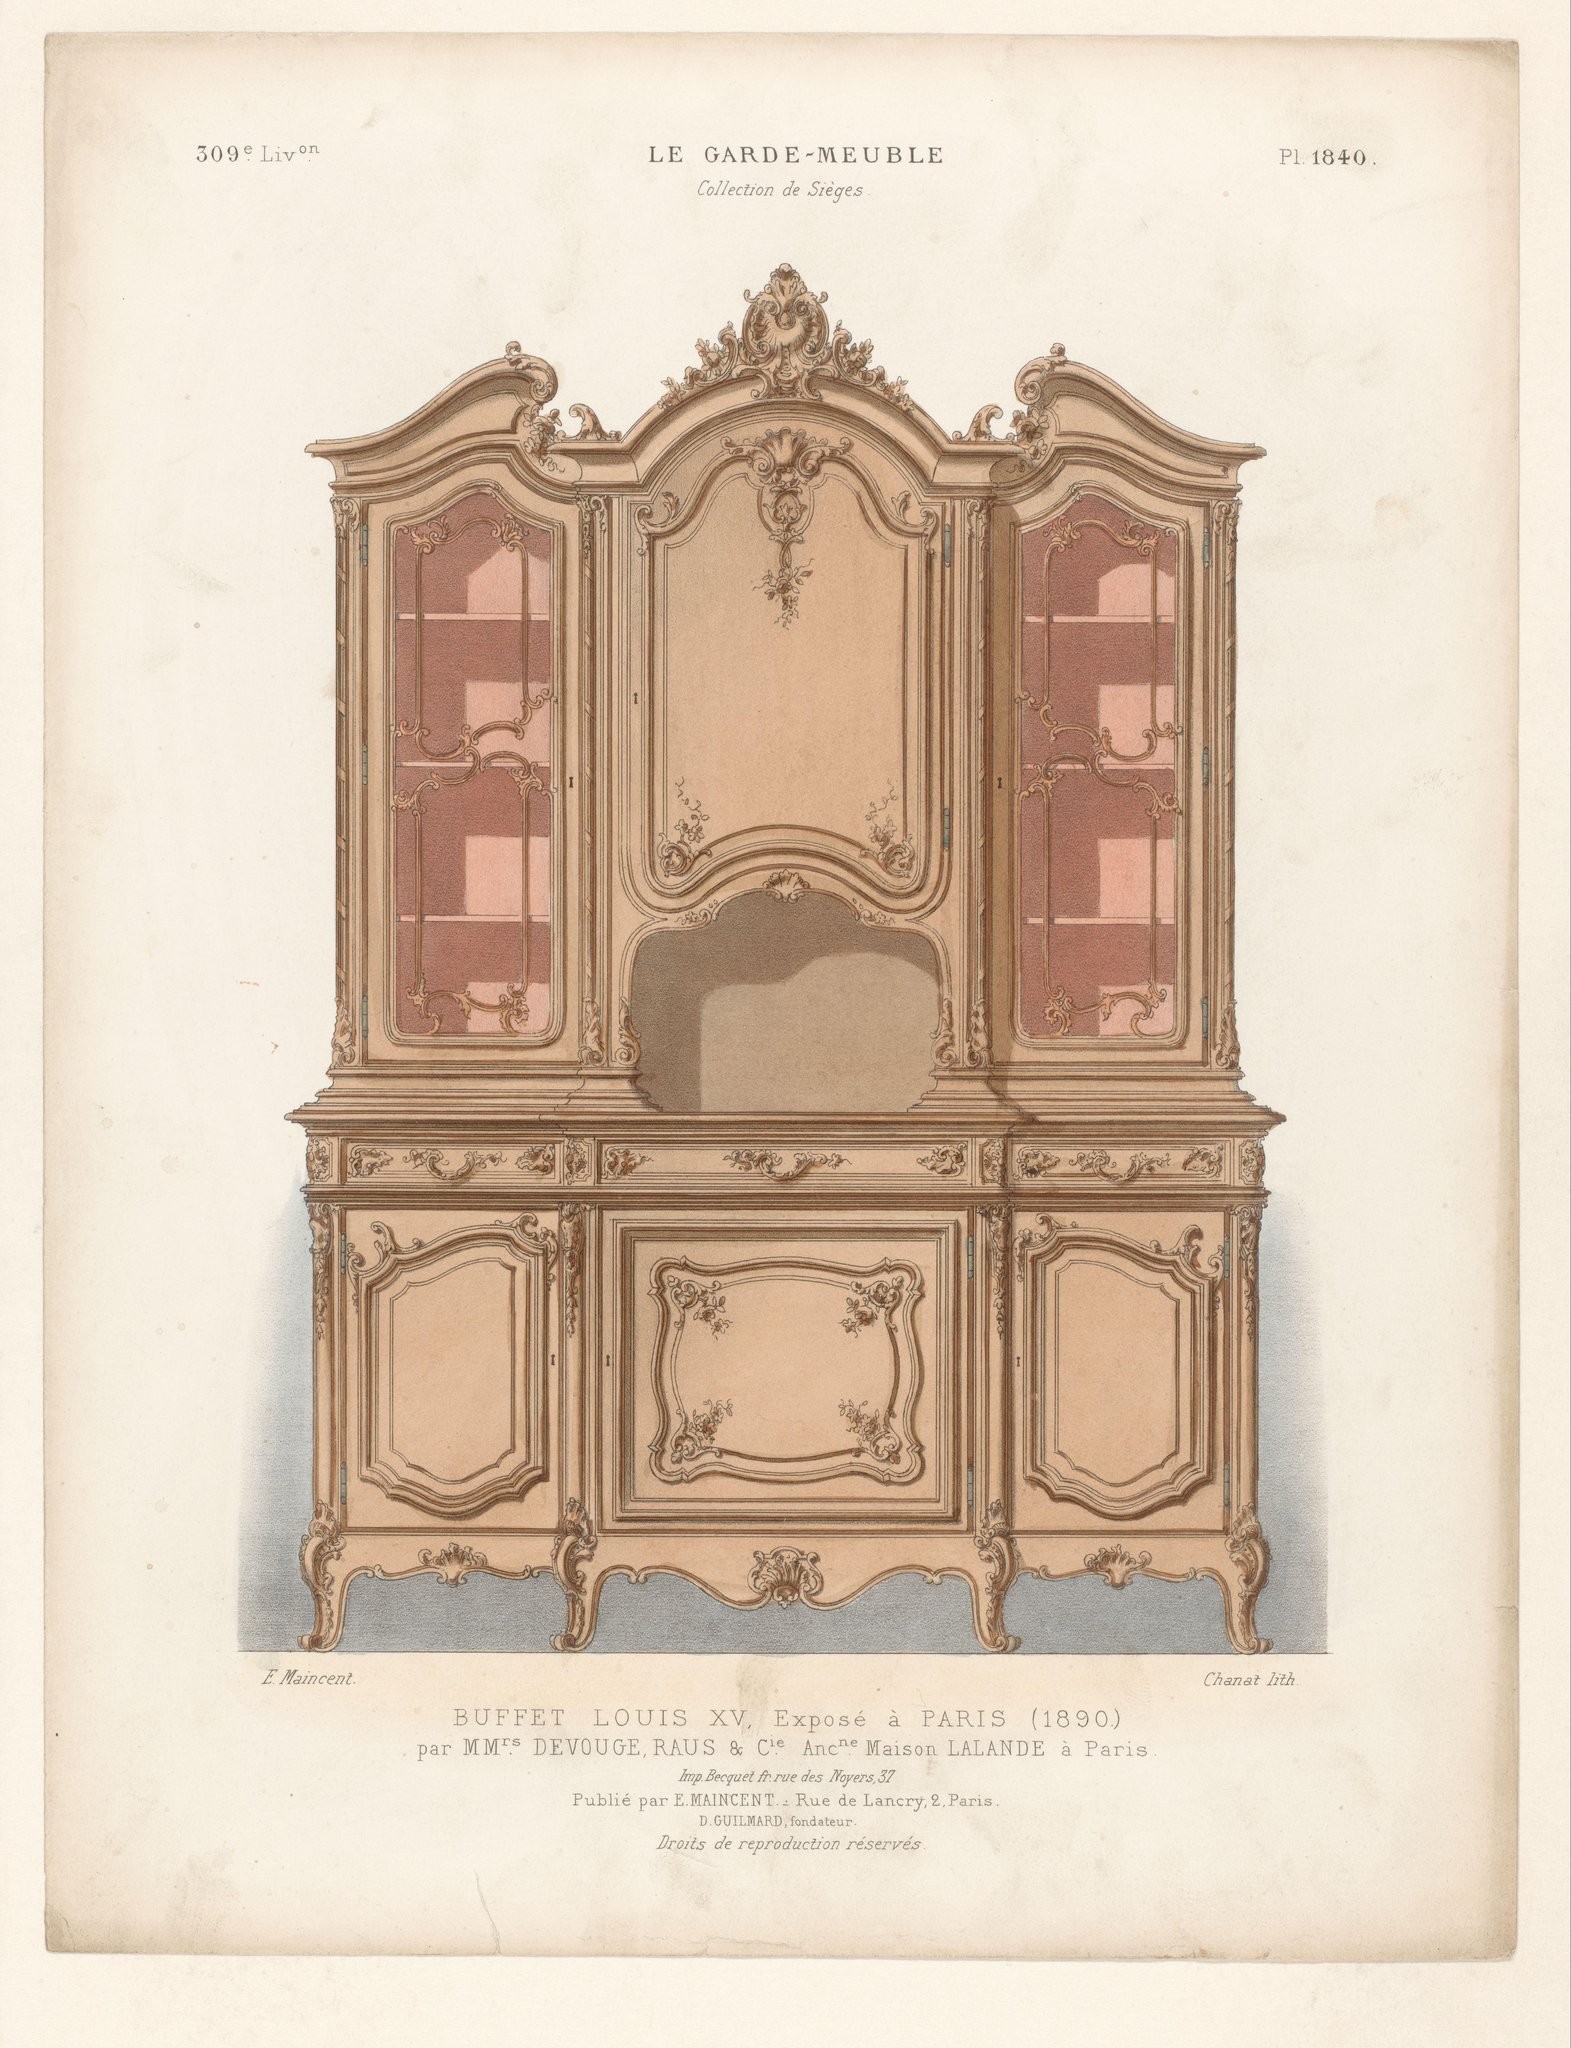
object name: print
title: Buffet Louis XV, Exposé à Paris (1890)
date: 1890-1895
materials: paper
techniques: hand coloring, lithograph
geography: paris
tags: furniture for storage, paris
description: Ieder Livraison in de serie Le Garde-Meuble bevat negen platen: drie 'sièges' (zitmeubels), drie 'meubles' (diverse meubels zoals tafels en kasten) en drie 'tentures' (gordijnen en draperieën).